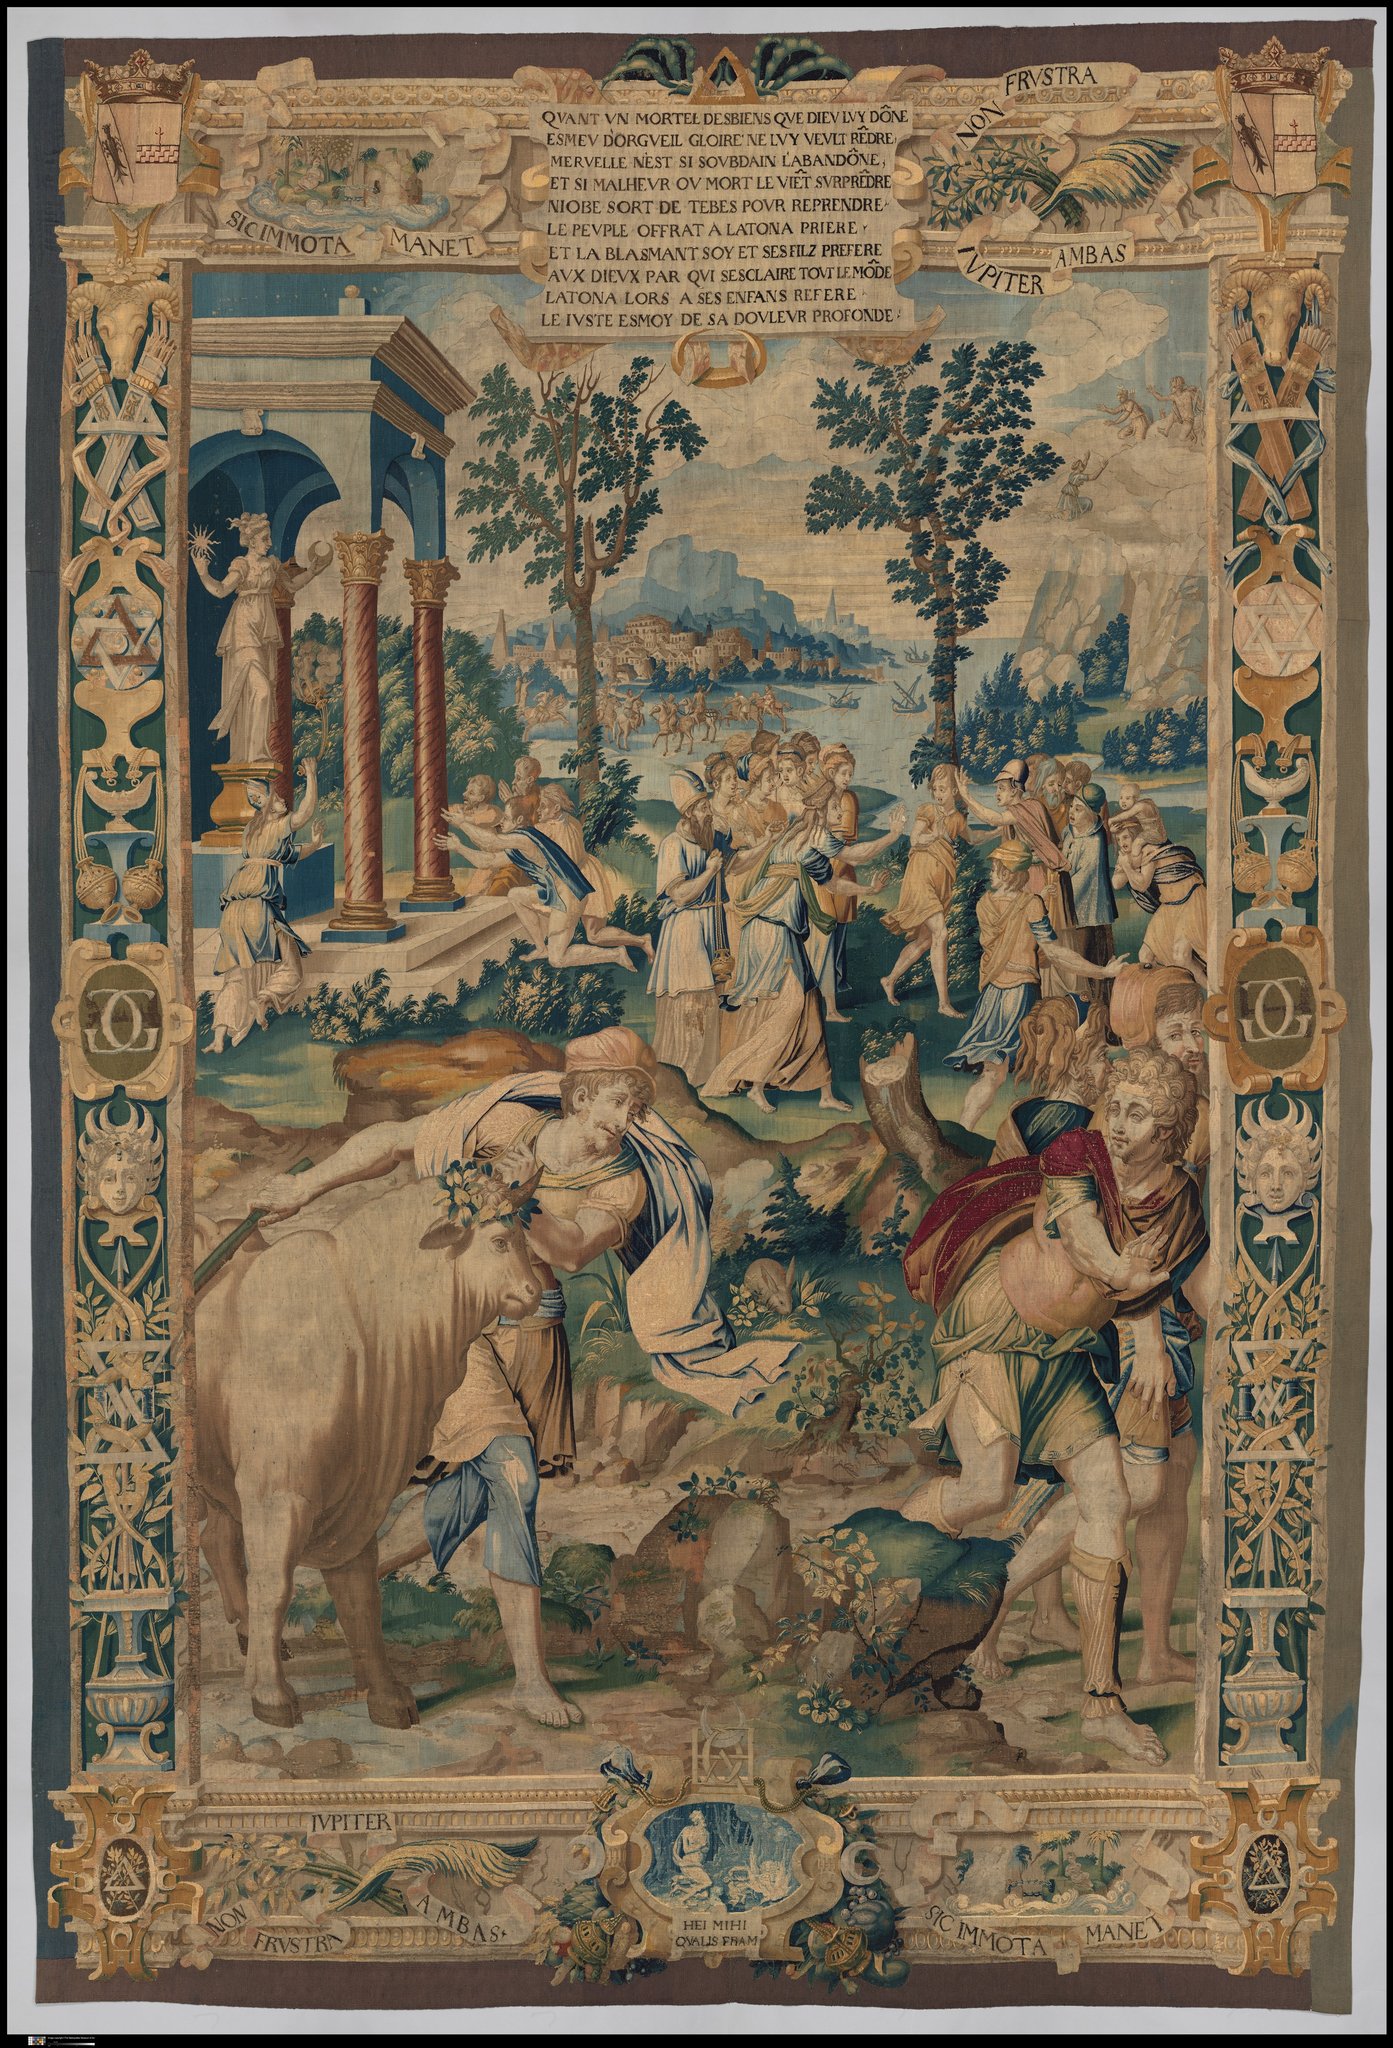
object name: tapestry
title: The Blasphemy of Niobe from Scenes from the Story of Diana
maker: jean cousin the elder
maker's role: designer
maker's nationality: french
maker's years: 1485-1565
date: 1547-1559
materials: silk, wool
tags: mythology,men,women,diana,bulls